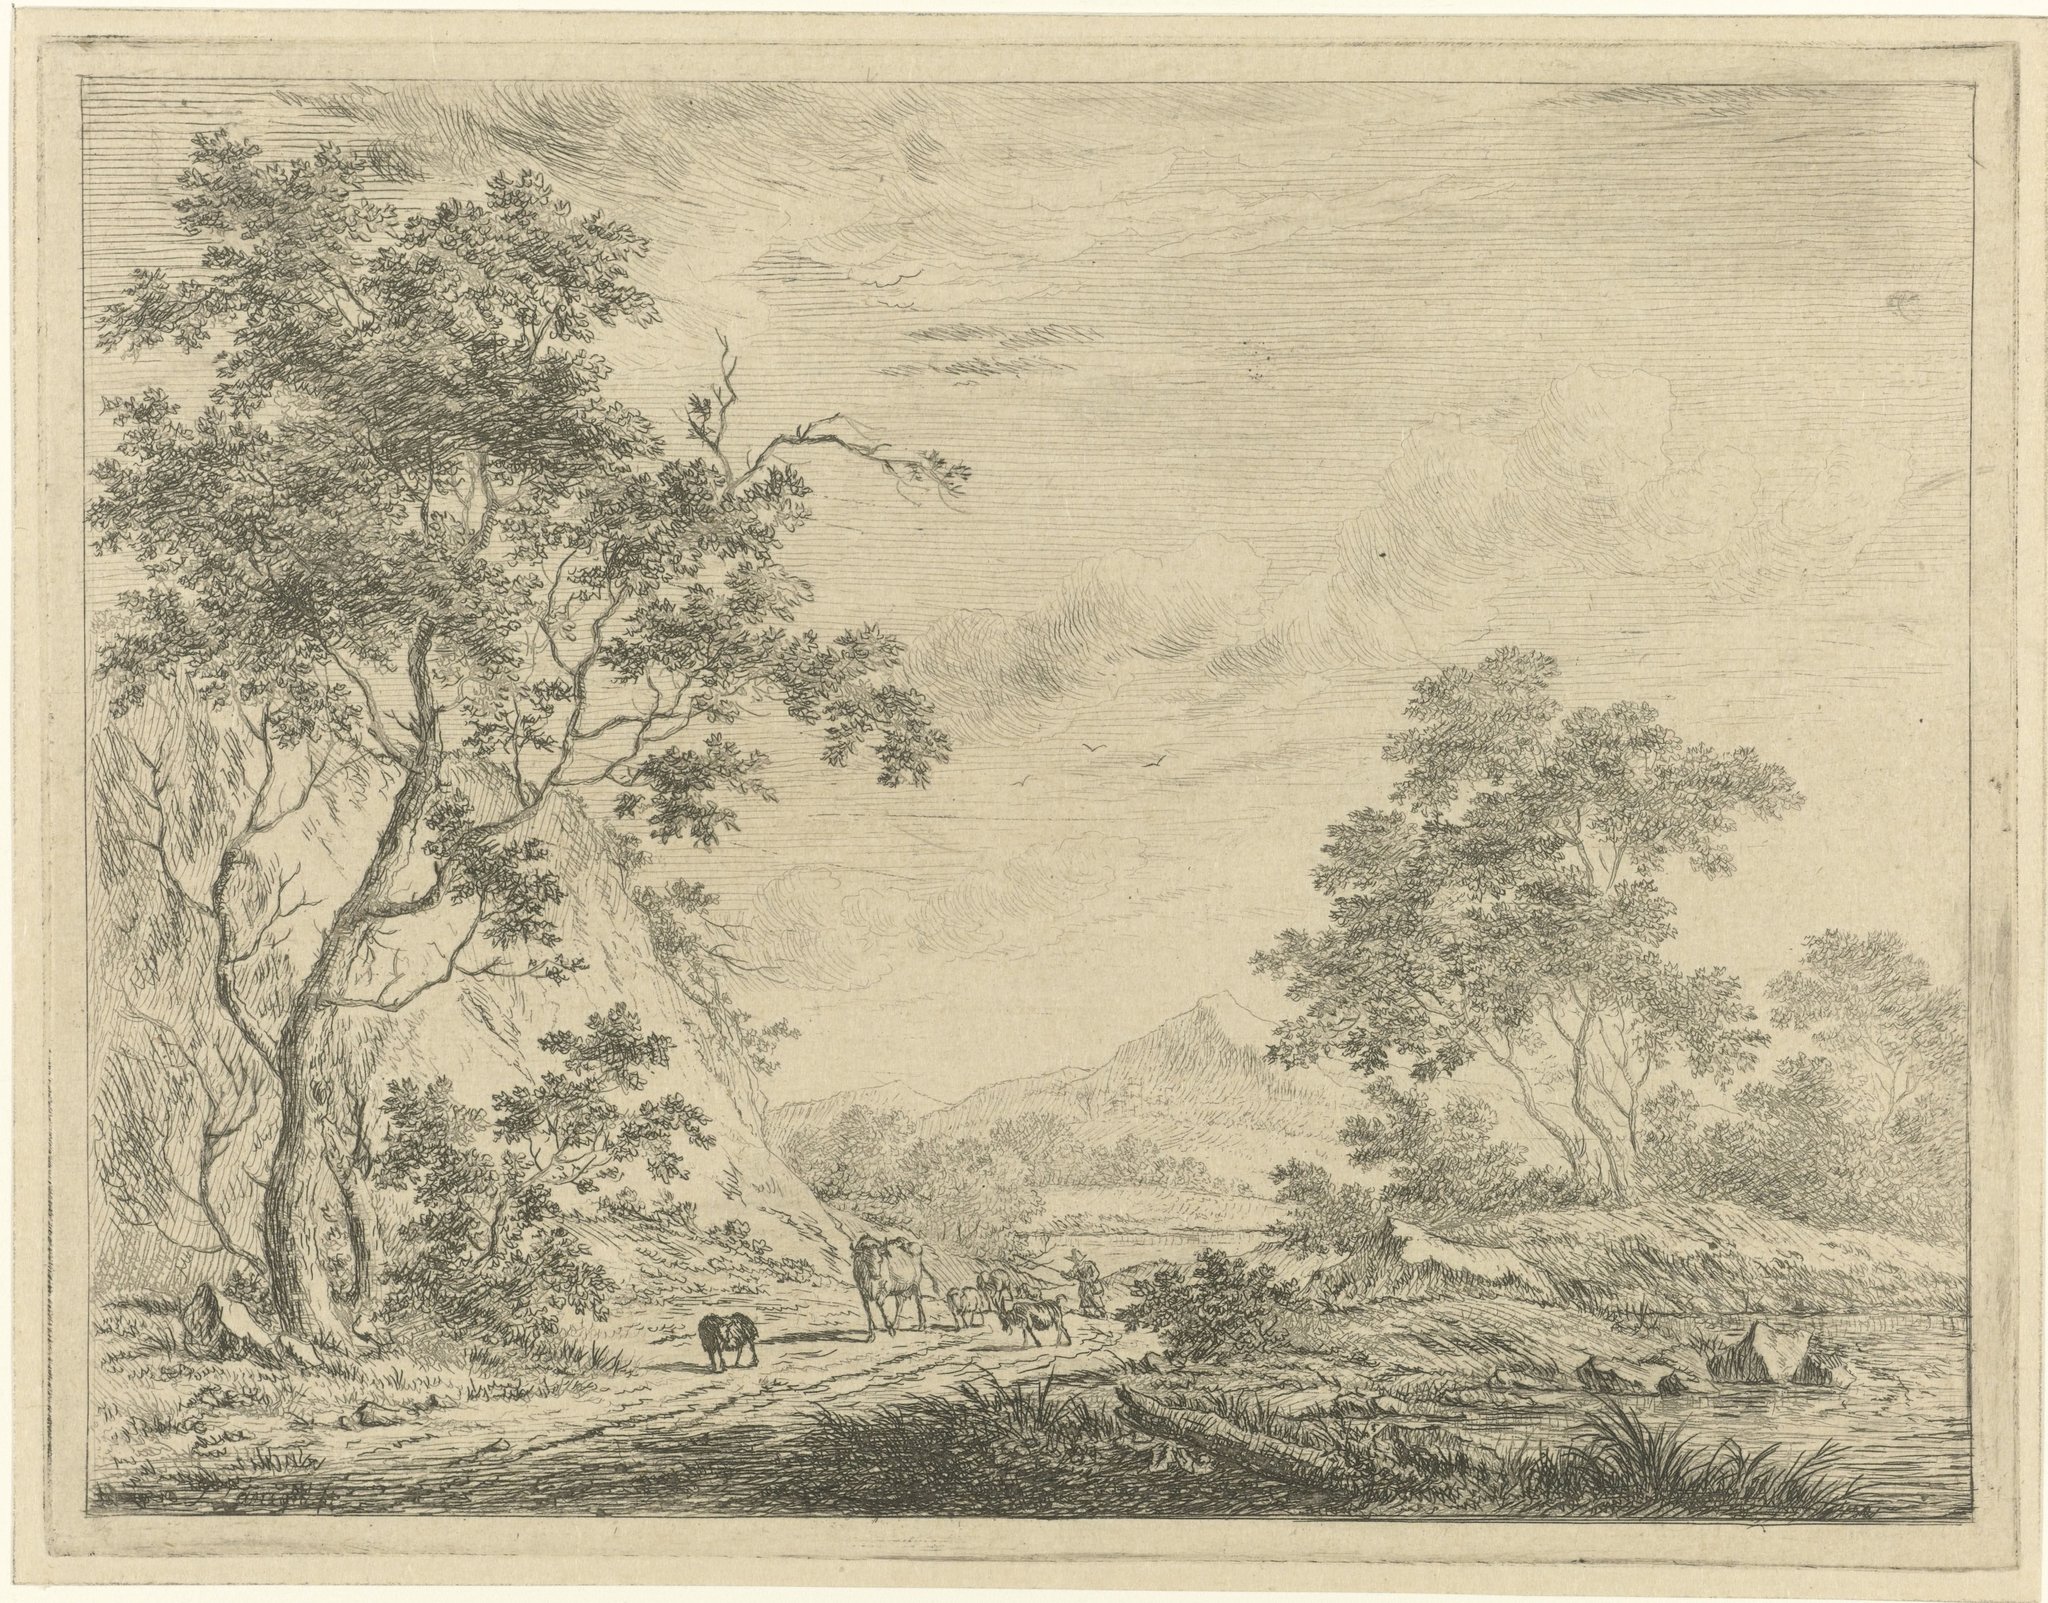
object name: print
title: Landschap met herder en vee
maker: johannes janson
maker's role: draughtsman, painter, print maker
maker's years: 1729-1784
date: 1761-1784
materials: paper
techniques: etching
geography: leiden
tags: landscapes (+ landscape with figures, staffage)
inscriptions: collector's mark: Lugt 240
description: Landschap met een herder die zijn vee over een pad langs een berg drijft. Rechts een meer. Prent uit een serie met landschappen met herders en vee.